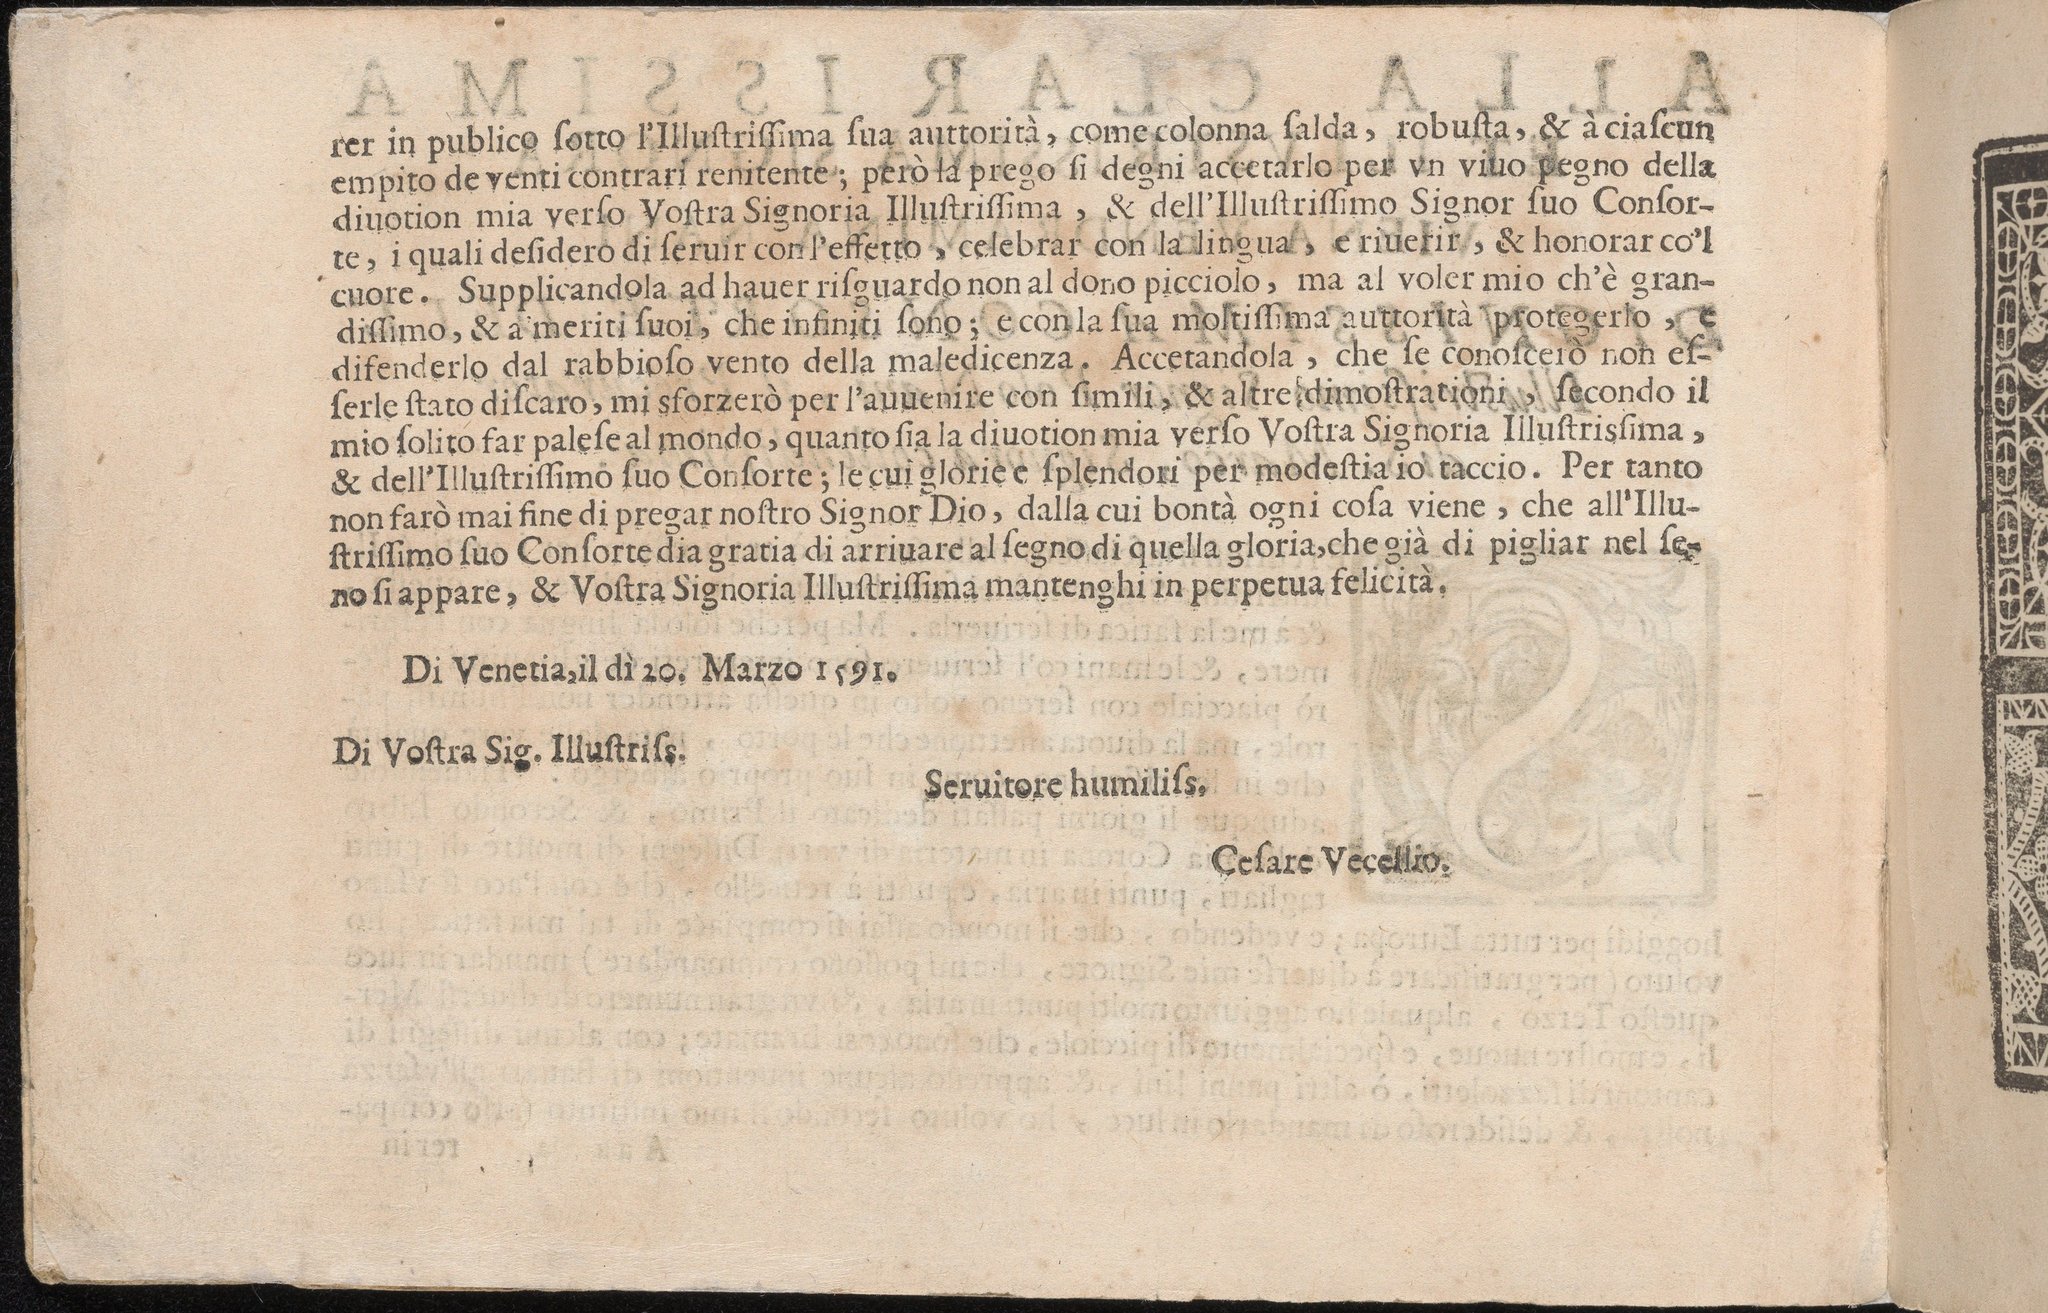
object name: book print ornament architecture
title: Corona delle Nobile et Virtuose Donne, Libro Terzo, page 2 (verso)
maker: cesare vecellio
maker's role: designer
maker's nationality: italian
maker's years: 1521-1601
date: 1620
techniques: woodcut